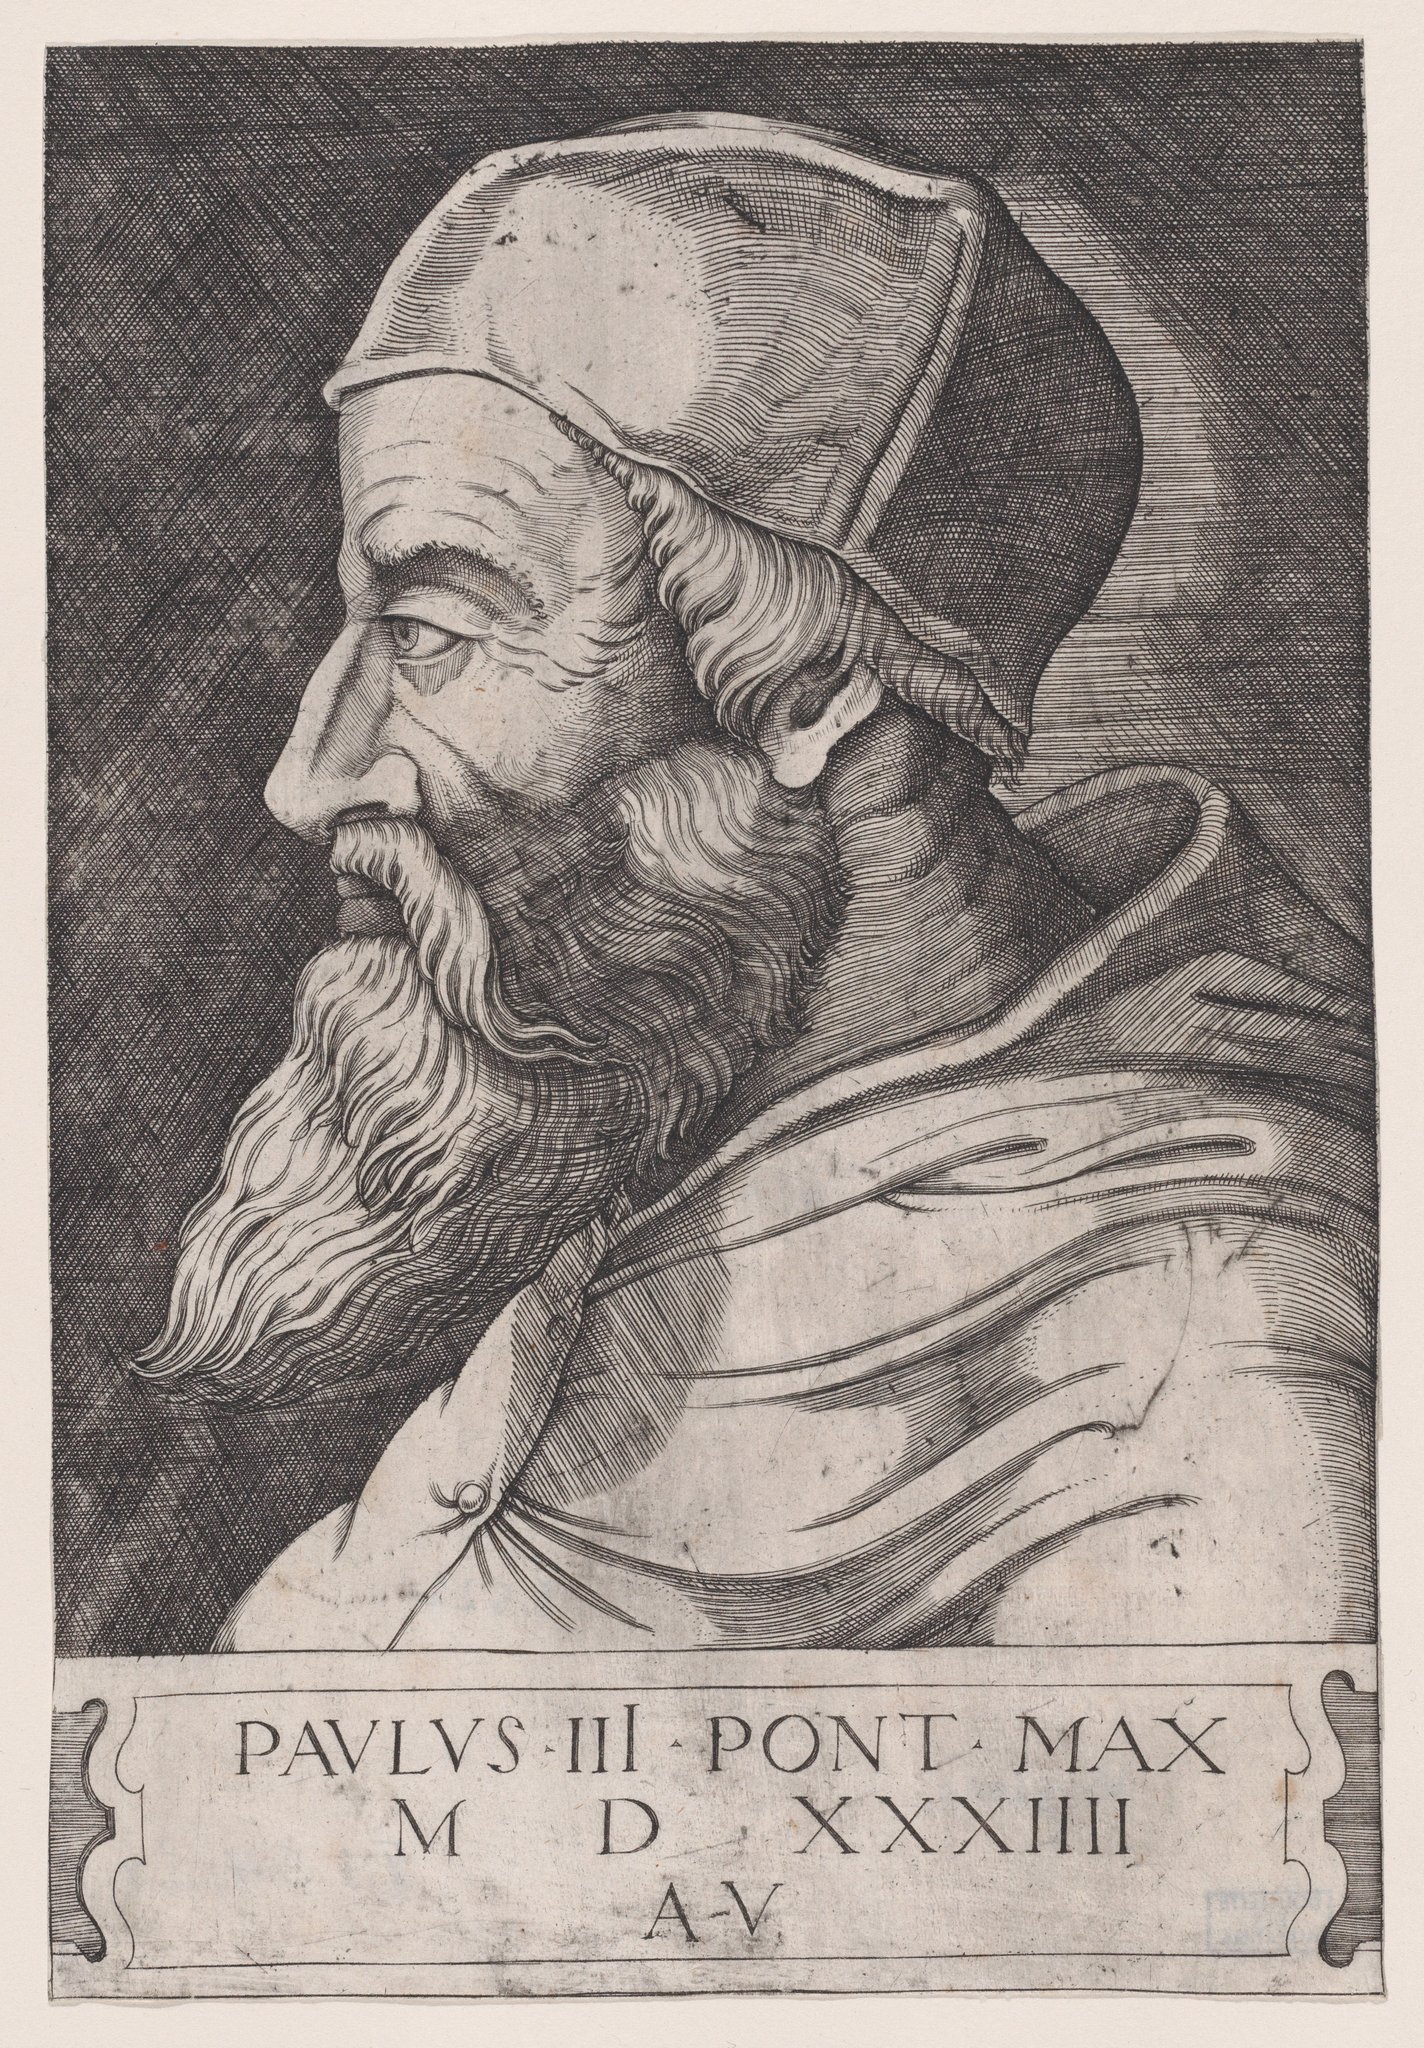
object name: print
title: Pope Paul III in a Skullcap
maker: agostino veneziano (agostino dei musi)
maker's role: artist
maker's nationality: italian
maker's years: 1490-1536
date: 1514-1536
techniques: engraving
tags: men,profiles,popes